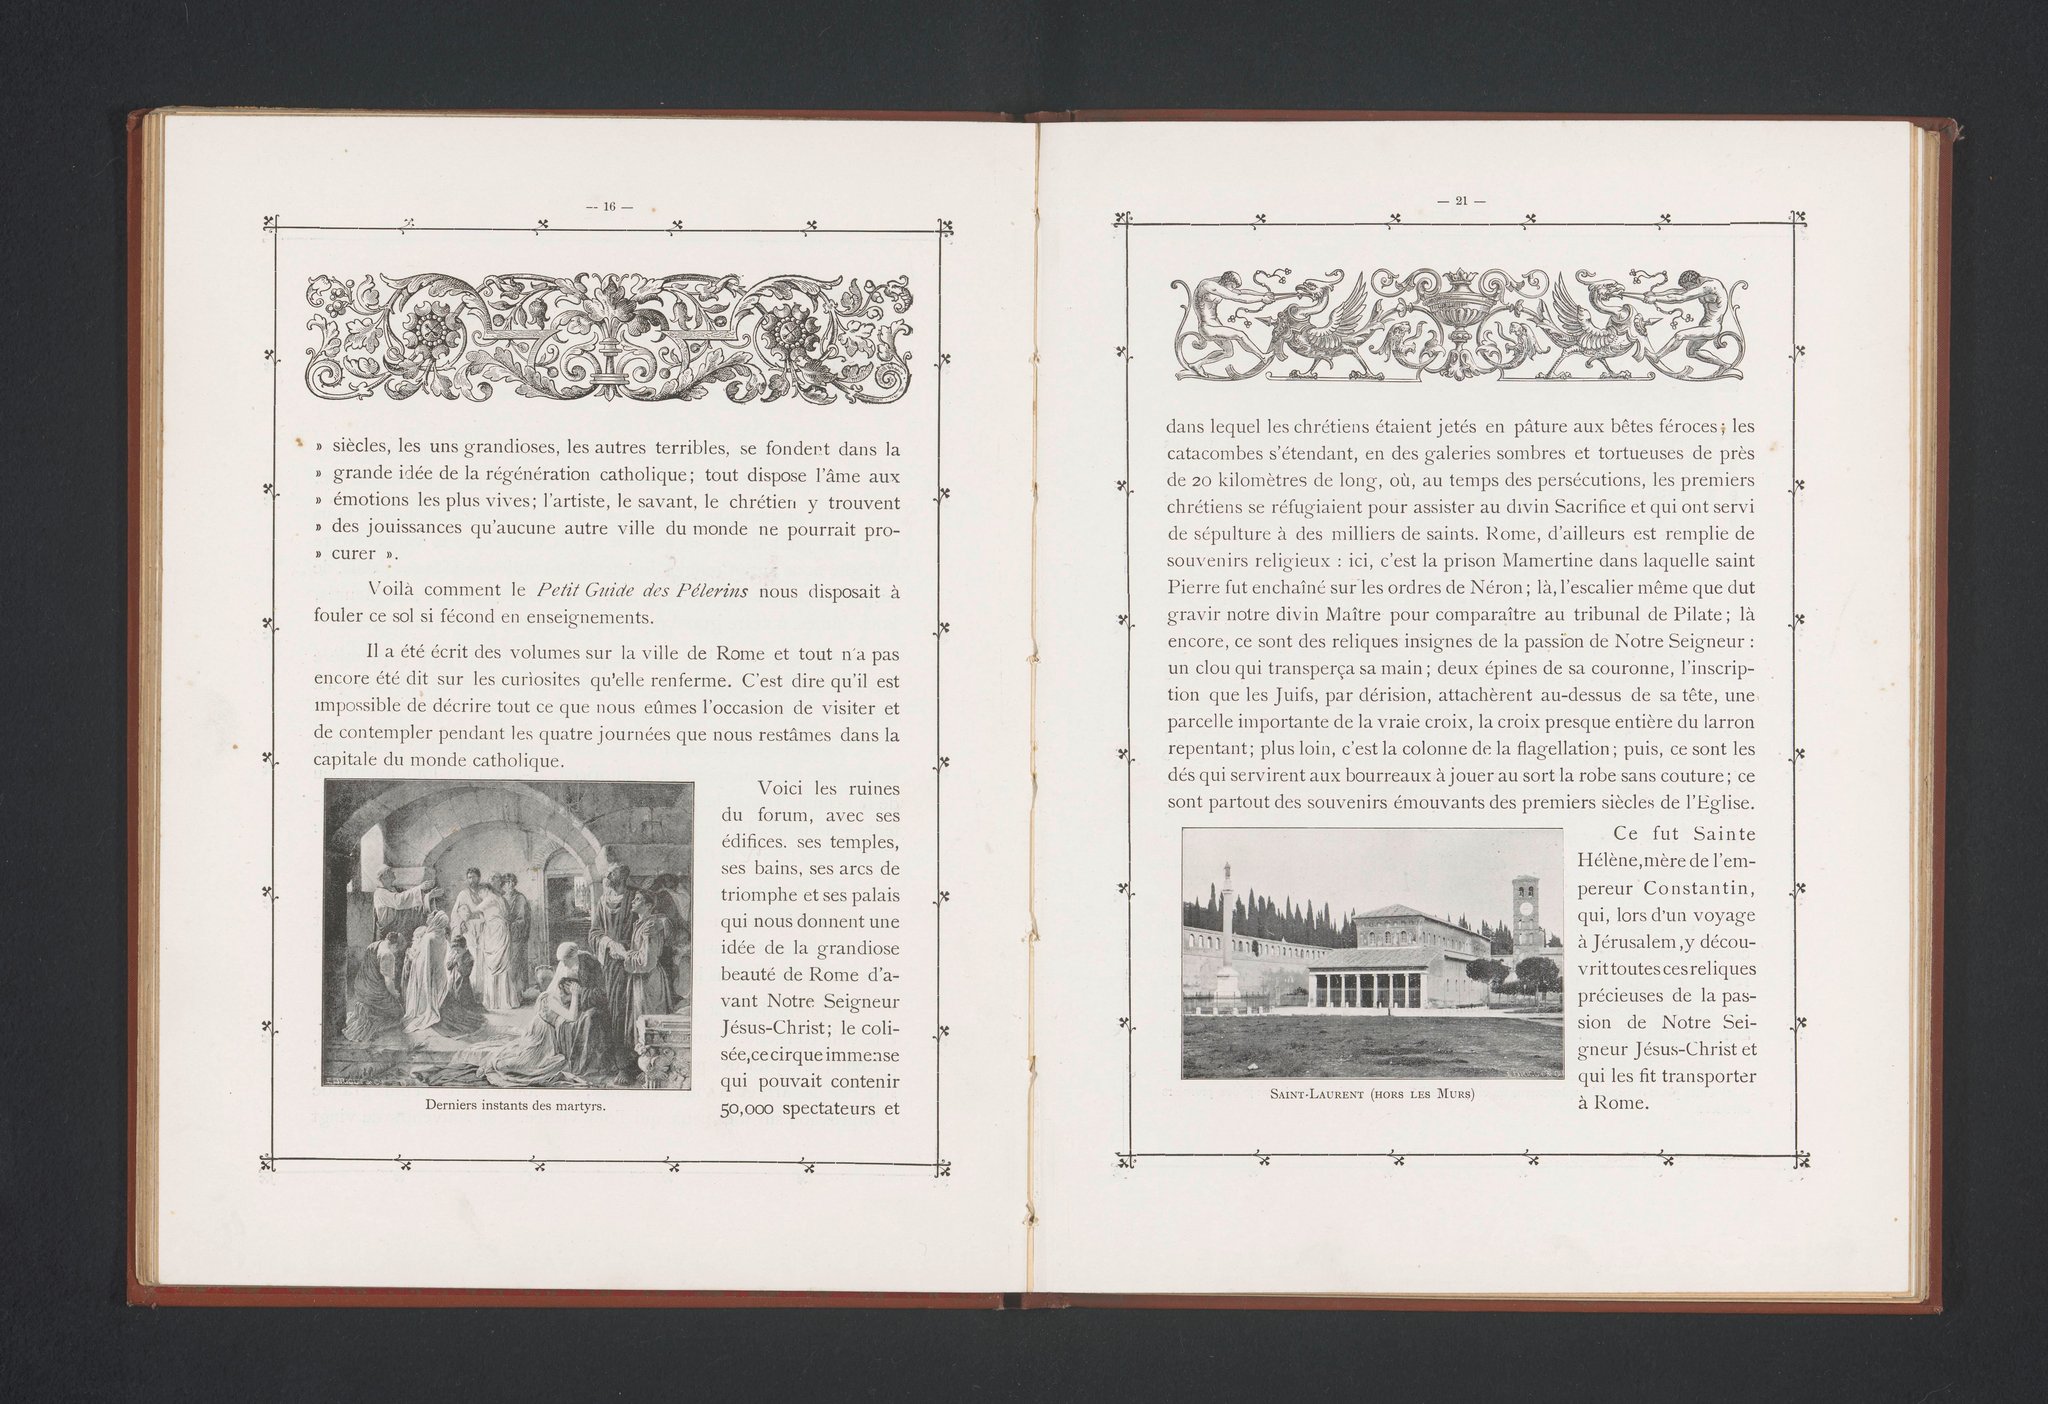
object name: reproduction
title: Derniers instants des martyrs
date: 1893-1898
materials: paper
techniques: autotype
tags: martyr(s) (often with palm-branches)